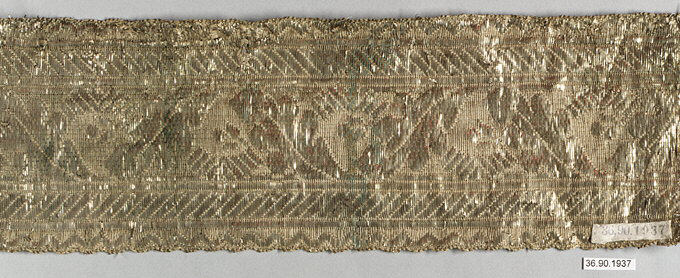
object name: galloon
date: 1701-1800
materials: metal thread